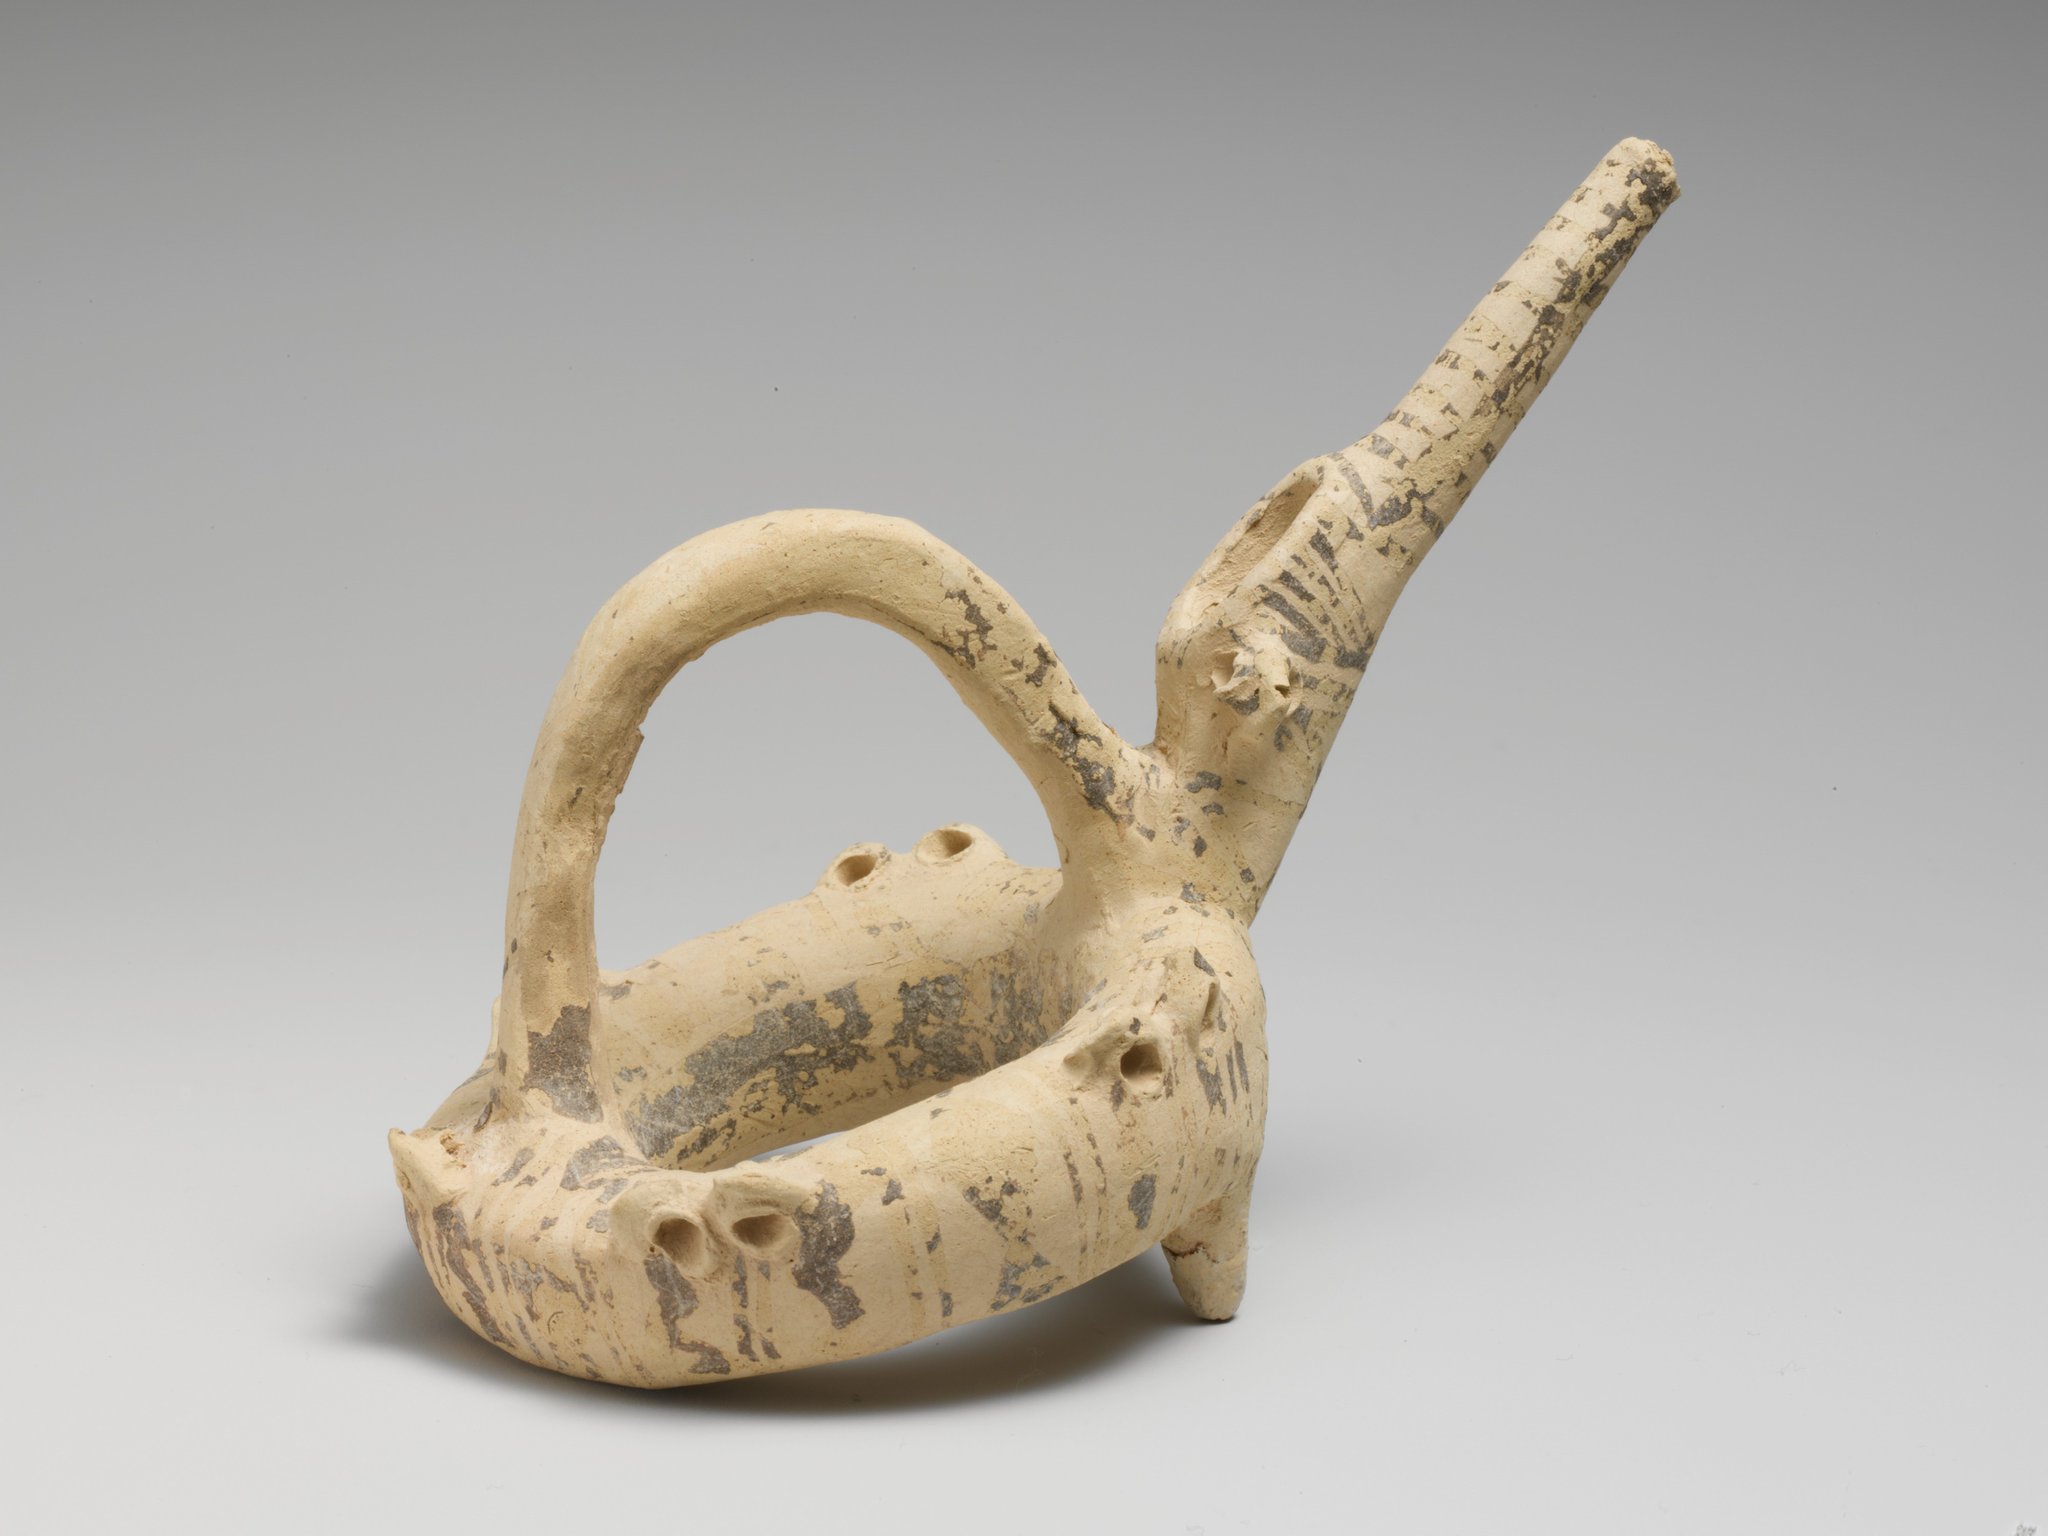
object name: ring vase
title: Terracotta ring-vase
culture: cypriot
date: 1900-1600 BCE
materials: terracotta